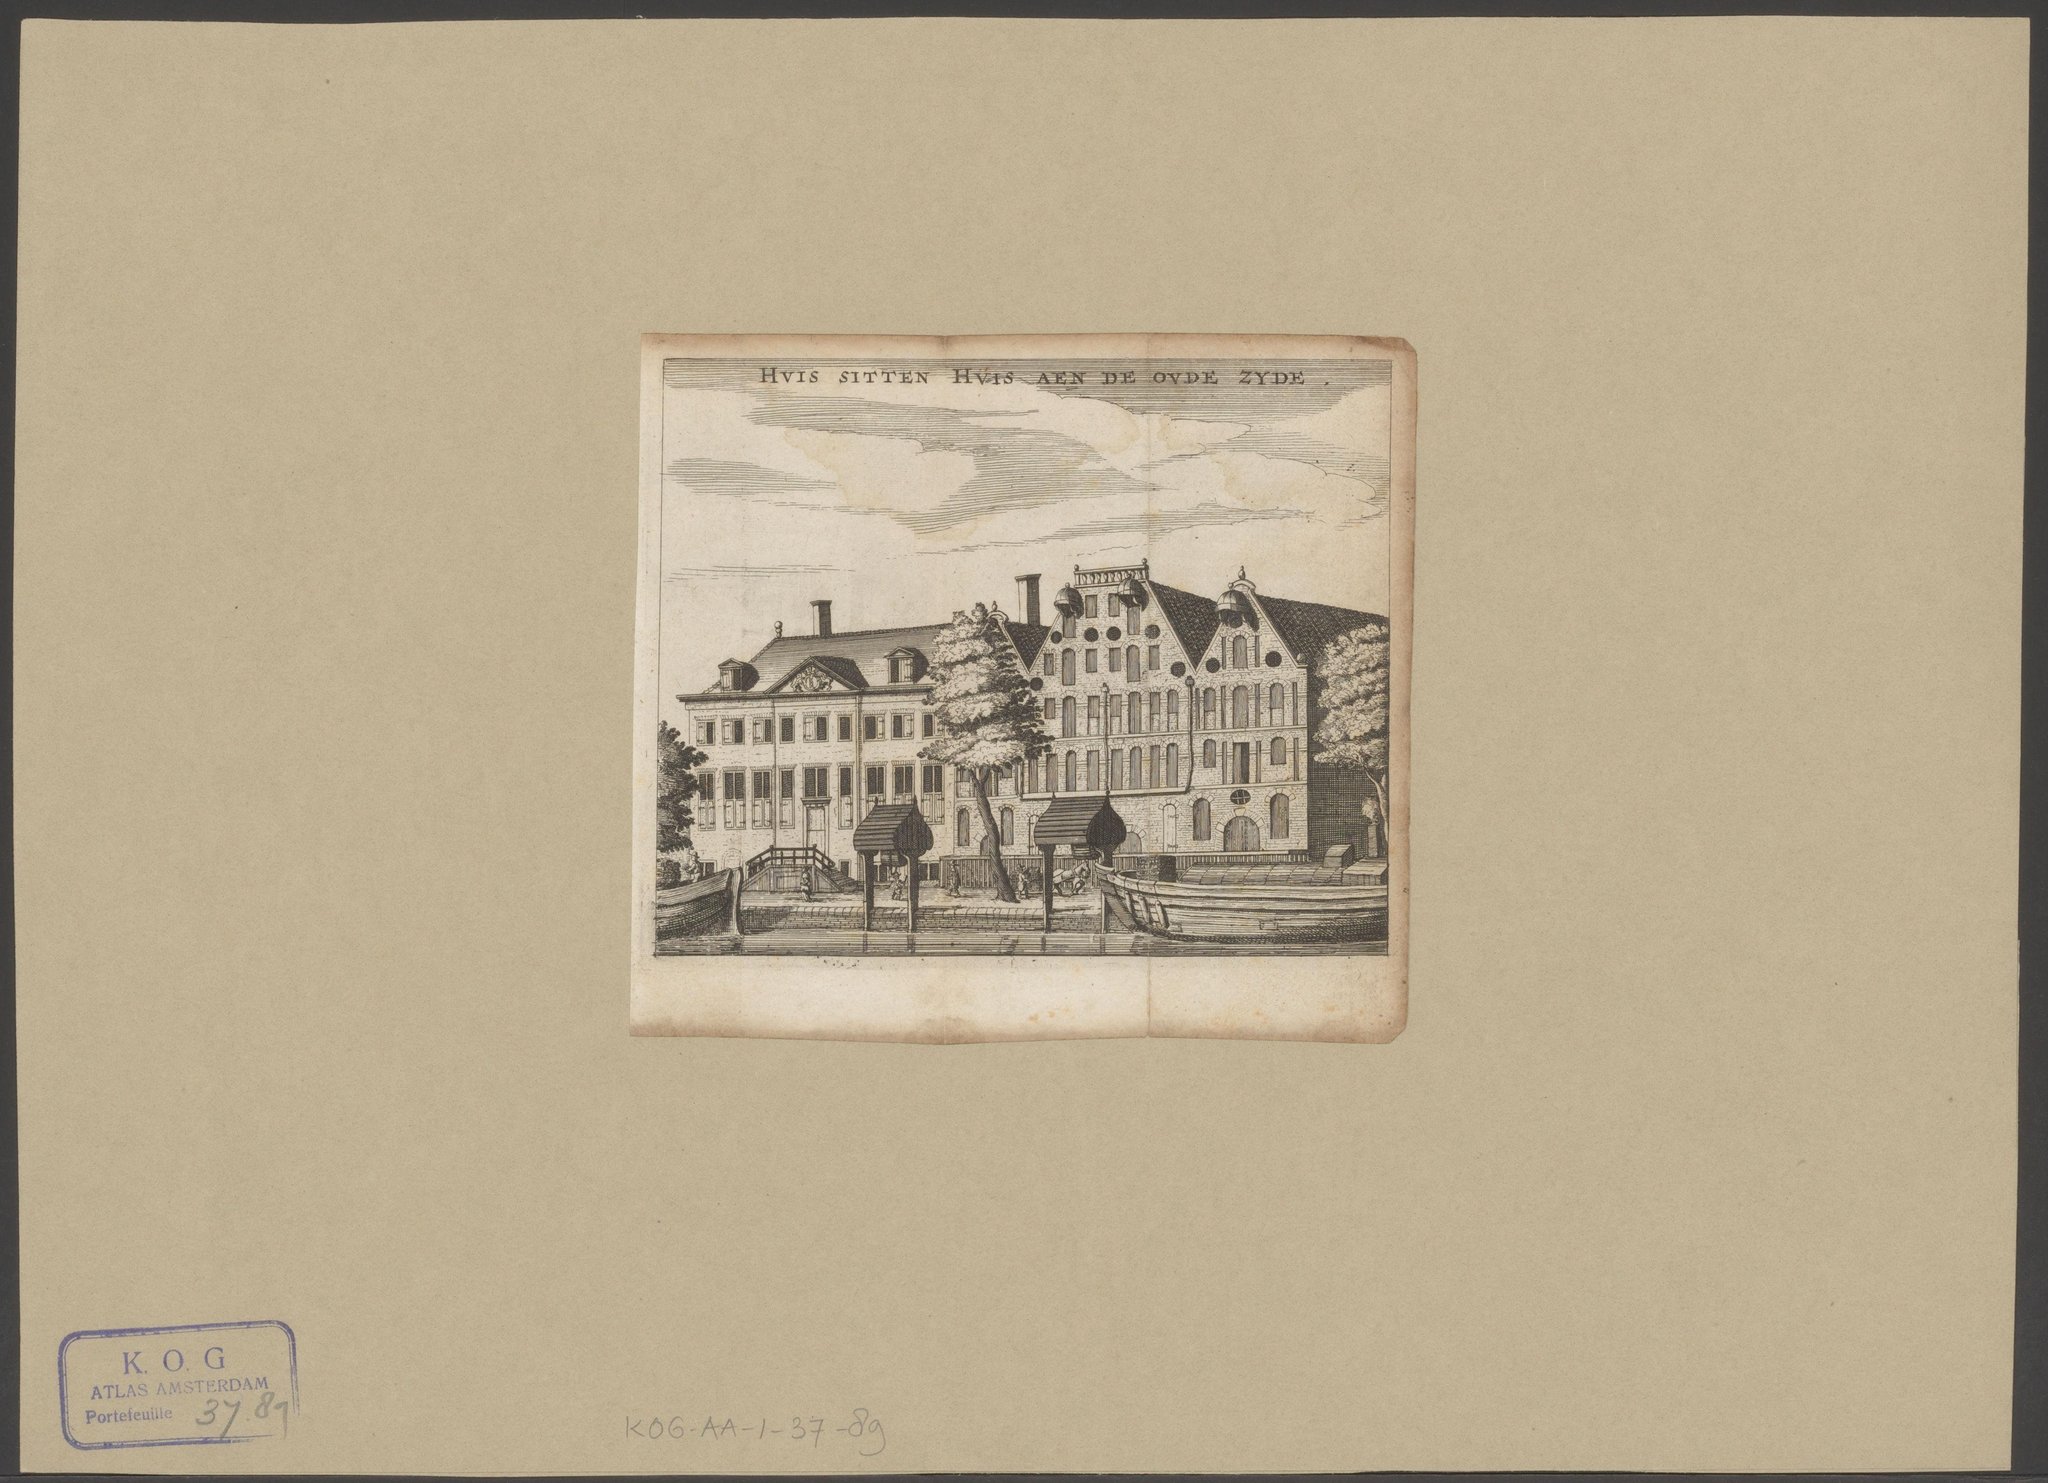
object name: print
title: Huis sitten Huis aen de Oude Zyde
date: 1664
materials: paper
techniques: engraving, etching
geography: amsterdam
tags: poorhouse, canals, waters (in city) (+ city(-scape) with figures, staffage)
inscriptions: collector's mark: Lugt 1641b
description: Huidige staat van prent ook gebruikt in: Fockens, Melchior. Beschrijvingh Der wijdt-vermaarde Koop-stadt Amstelredam (…). 3de druk. Amsterdam: Marcus Willemsz. Doornick, 1664. En in: Zesen, Philipp von. Beschreibung der Stadt Amsterdam (…). Amsterdam: Marcus Wilhelm Doornick, 1664. Tweede bekende staat (met toevoeging Franse titel) ook gebruikt in: Domselaer, Tobias en Isaac Commelin. Beschryvinge van Amsterdam (…). 6 dln. Amsterdam: Marcus Willemsz. Doornick, 1665, dl. 4, p. 126. Derde bekende staat (rechtsboven genummerd: 31) ook gebruikt in verschillende latere zeventiende- en achttiende-eeuwse publicaties.